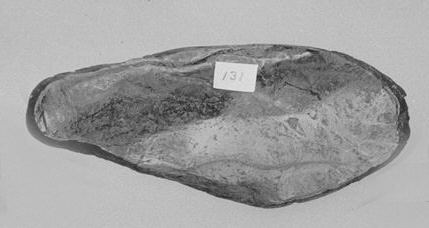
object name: fragment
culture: russian, siberia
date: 1902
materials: jade